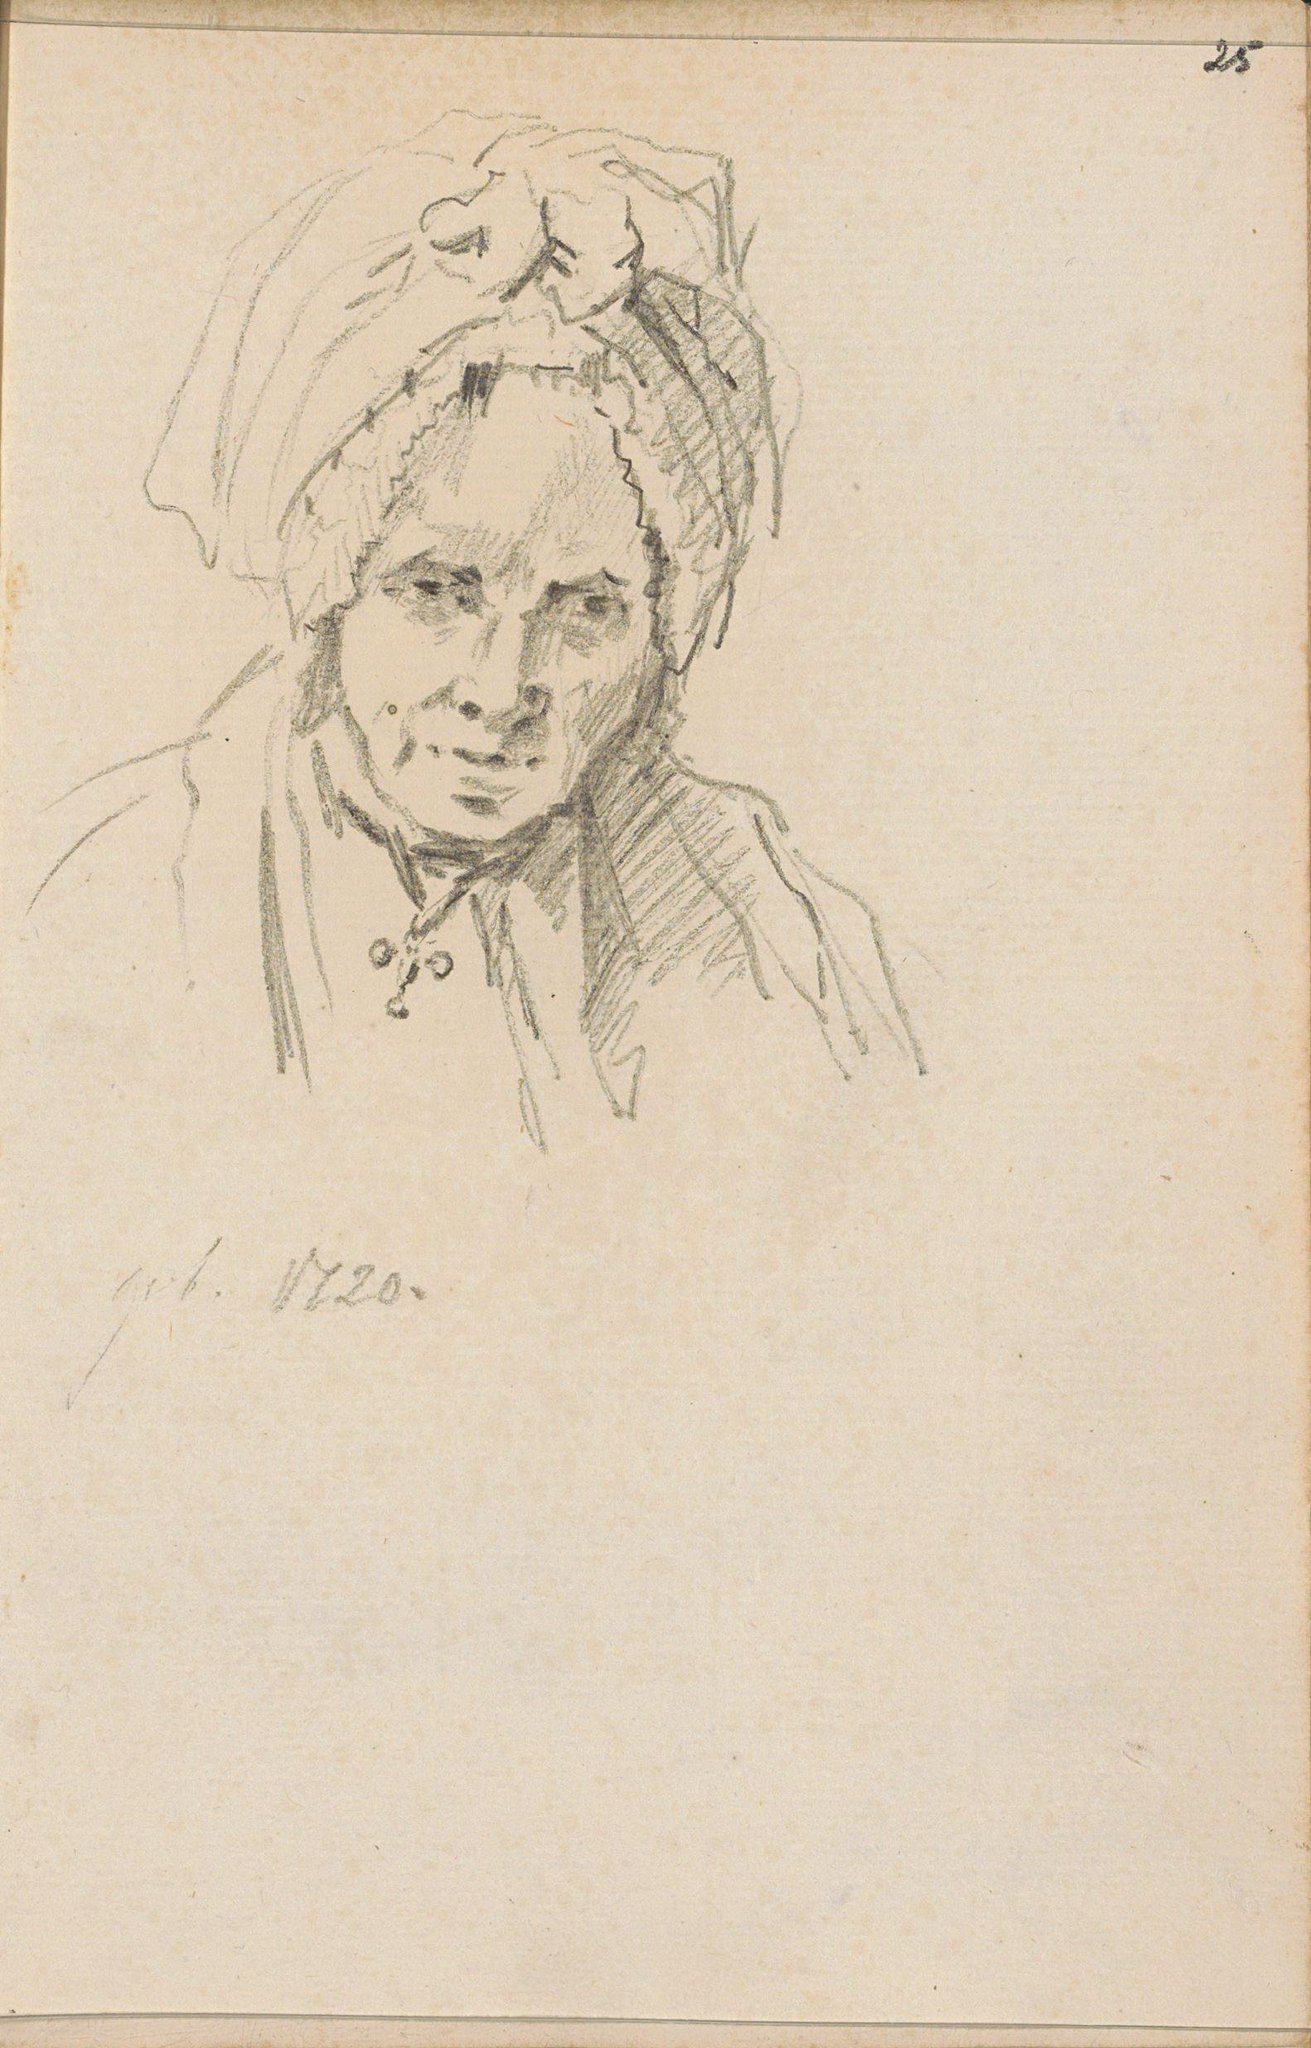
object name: sketchbook leaf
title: Portret van een vrouw met een muts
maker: jacob perkois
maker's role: draughtsman, print maker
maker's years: 1756-1804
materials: paper, pencil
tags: adult woman, head-gear: cap (+ men's clothes)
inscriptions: annotation: ‘geb. 1720’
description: De vrouw draagt een halsketting. Bladzijde 25 uit een schetsboek met 78 bladzijden.